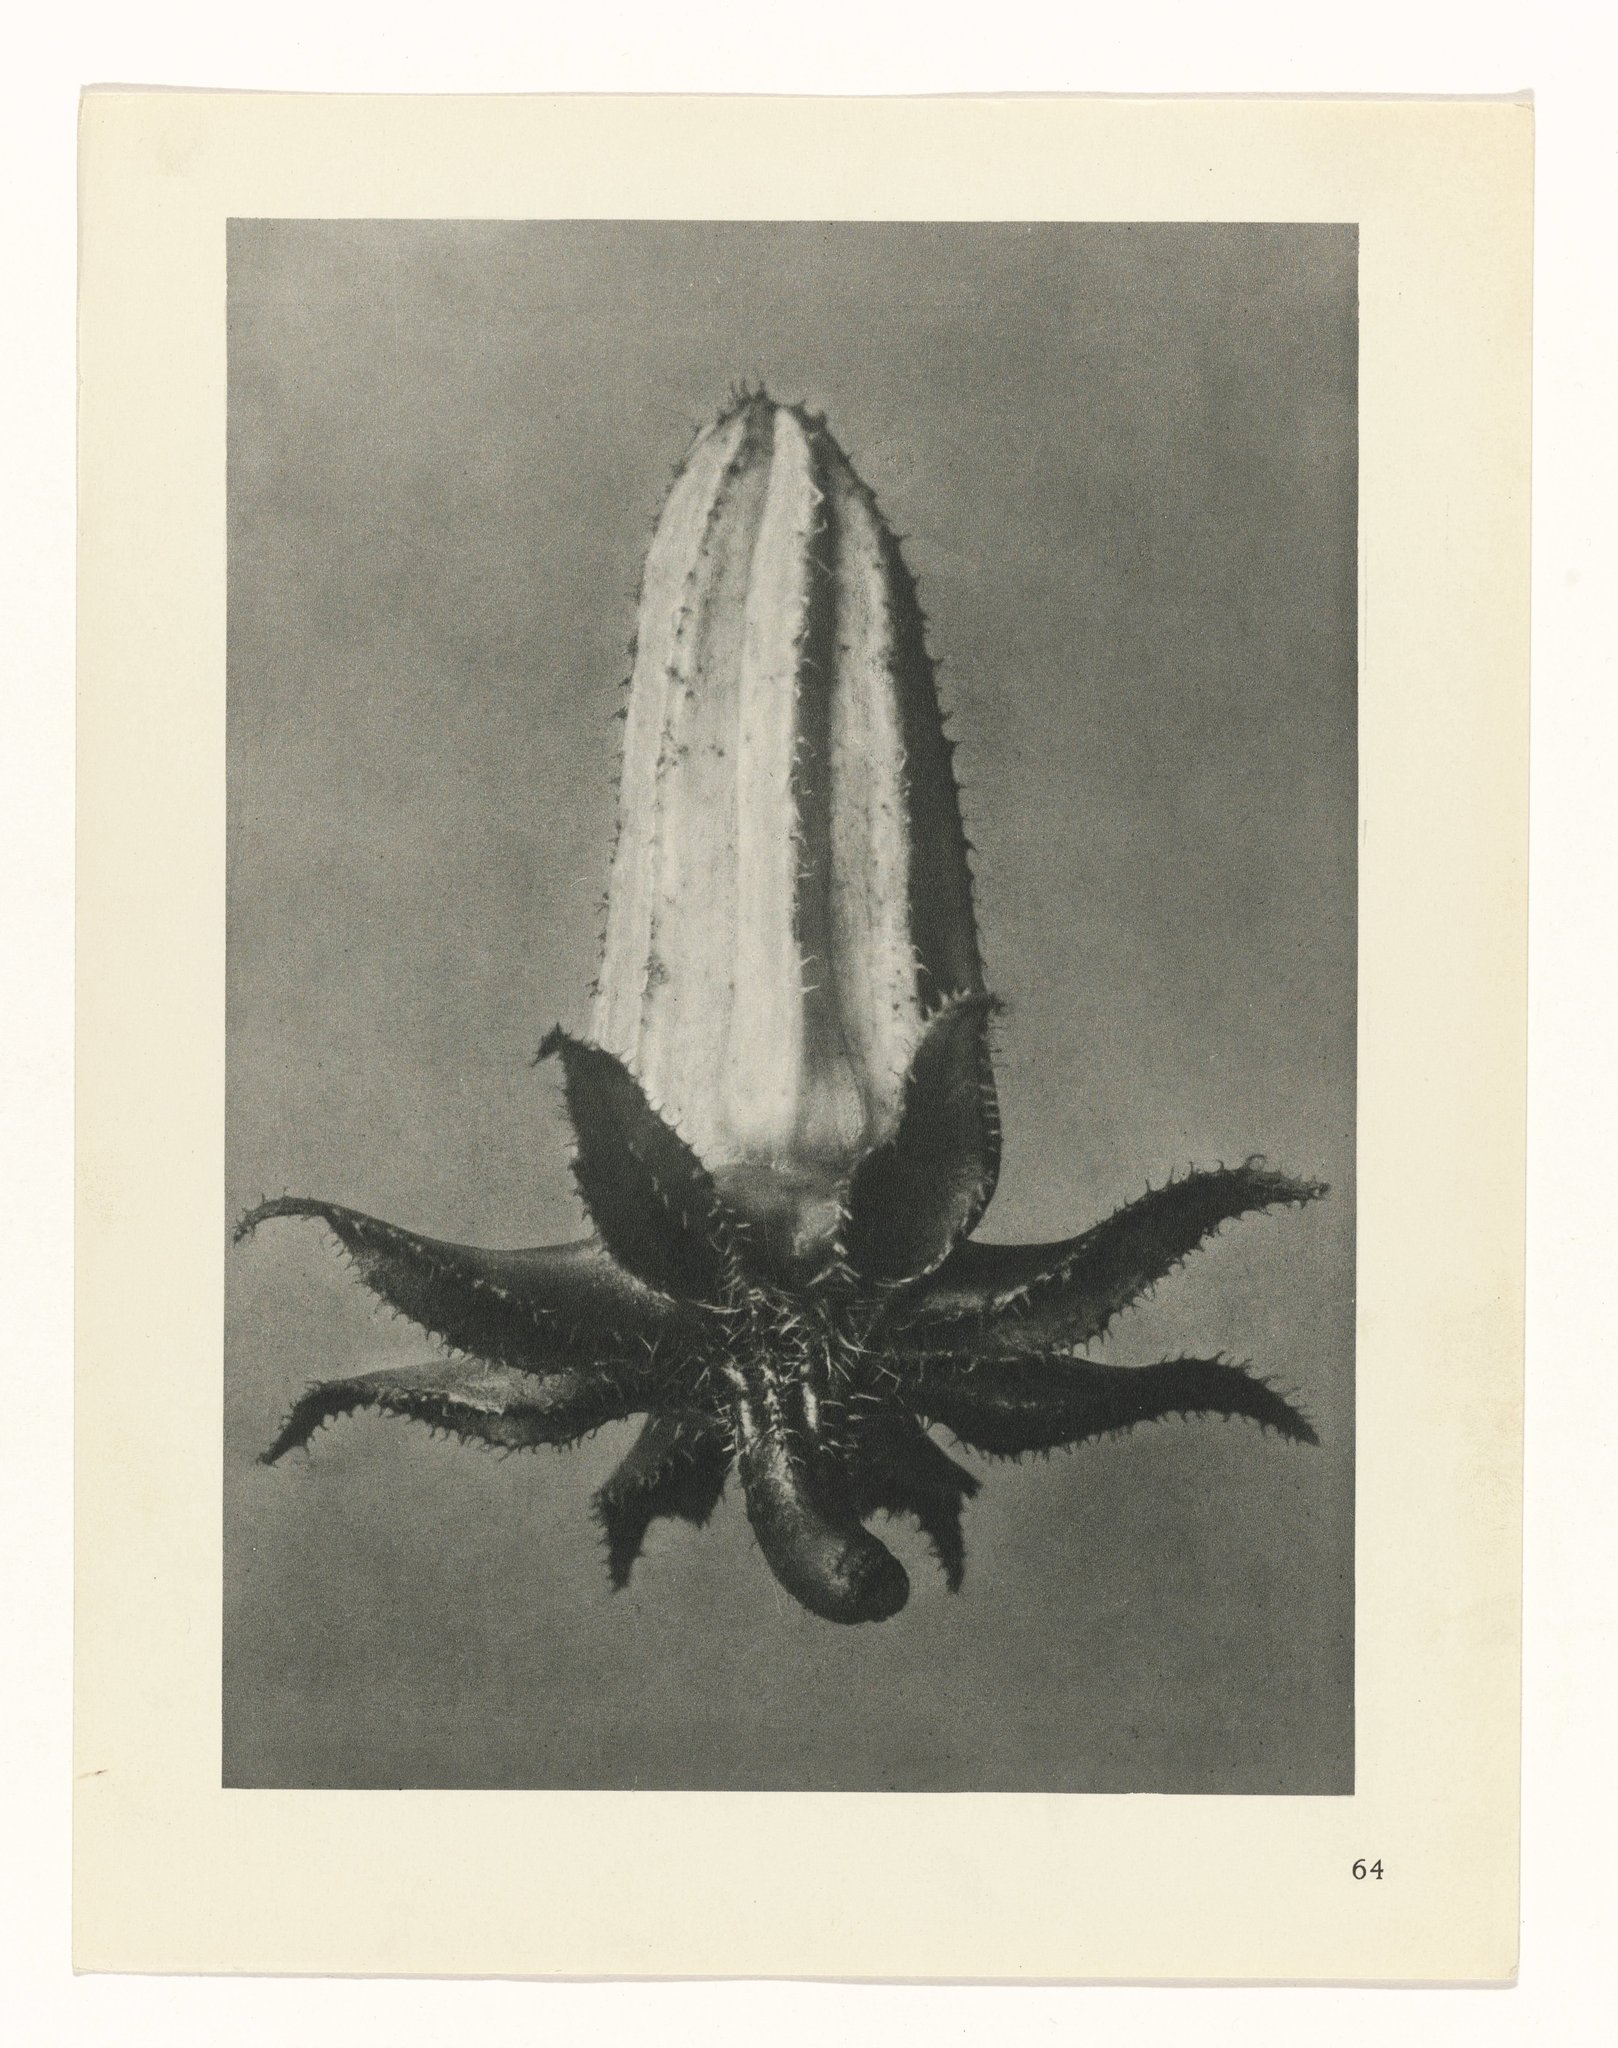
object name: photograph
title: Urformen der Kunst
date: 1928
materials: ink, paper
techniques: rotogravure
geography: berlin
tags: plants (in general)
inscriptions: number: ‘64’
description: facher Vergrößerung. Afkomstig uit losbladige uitgave.